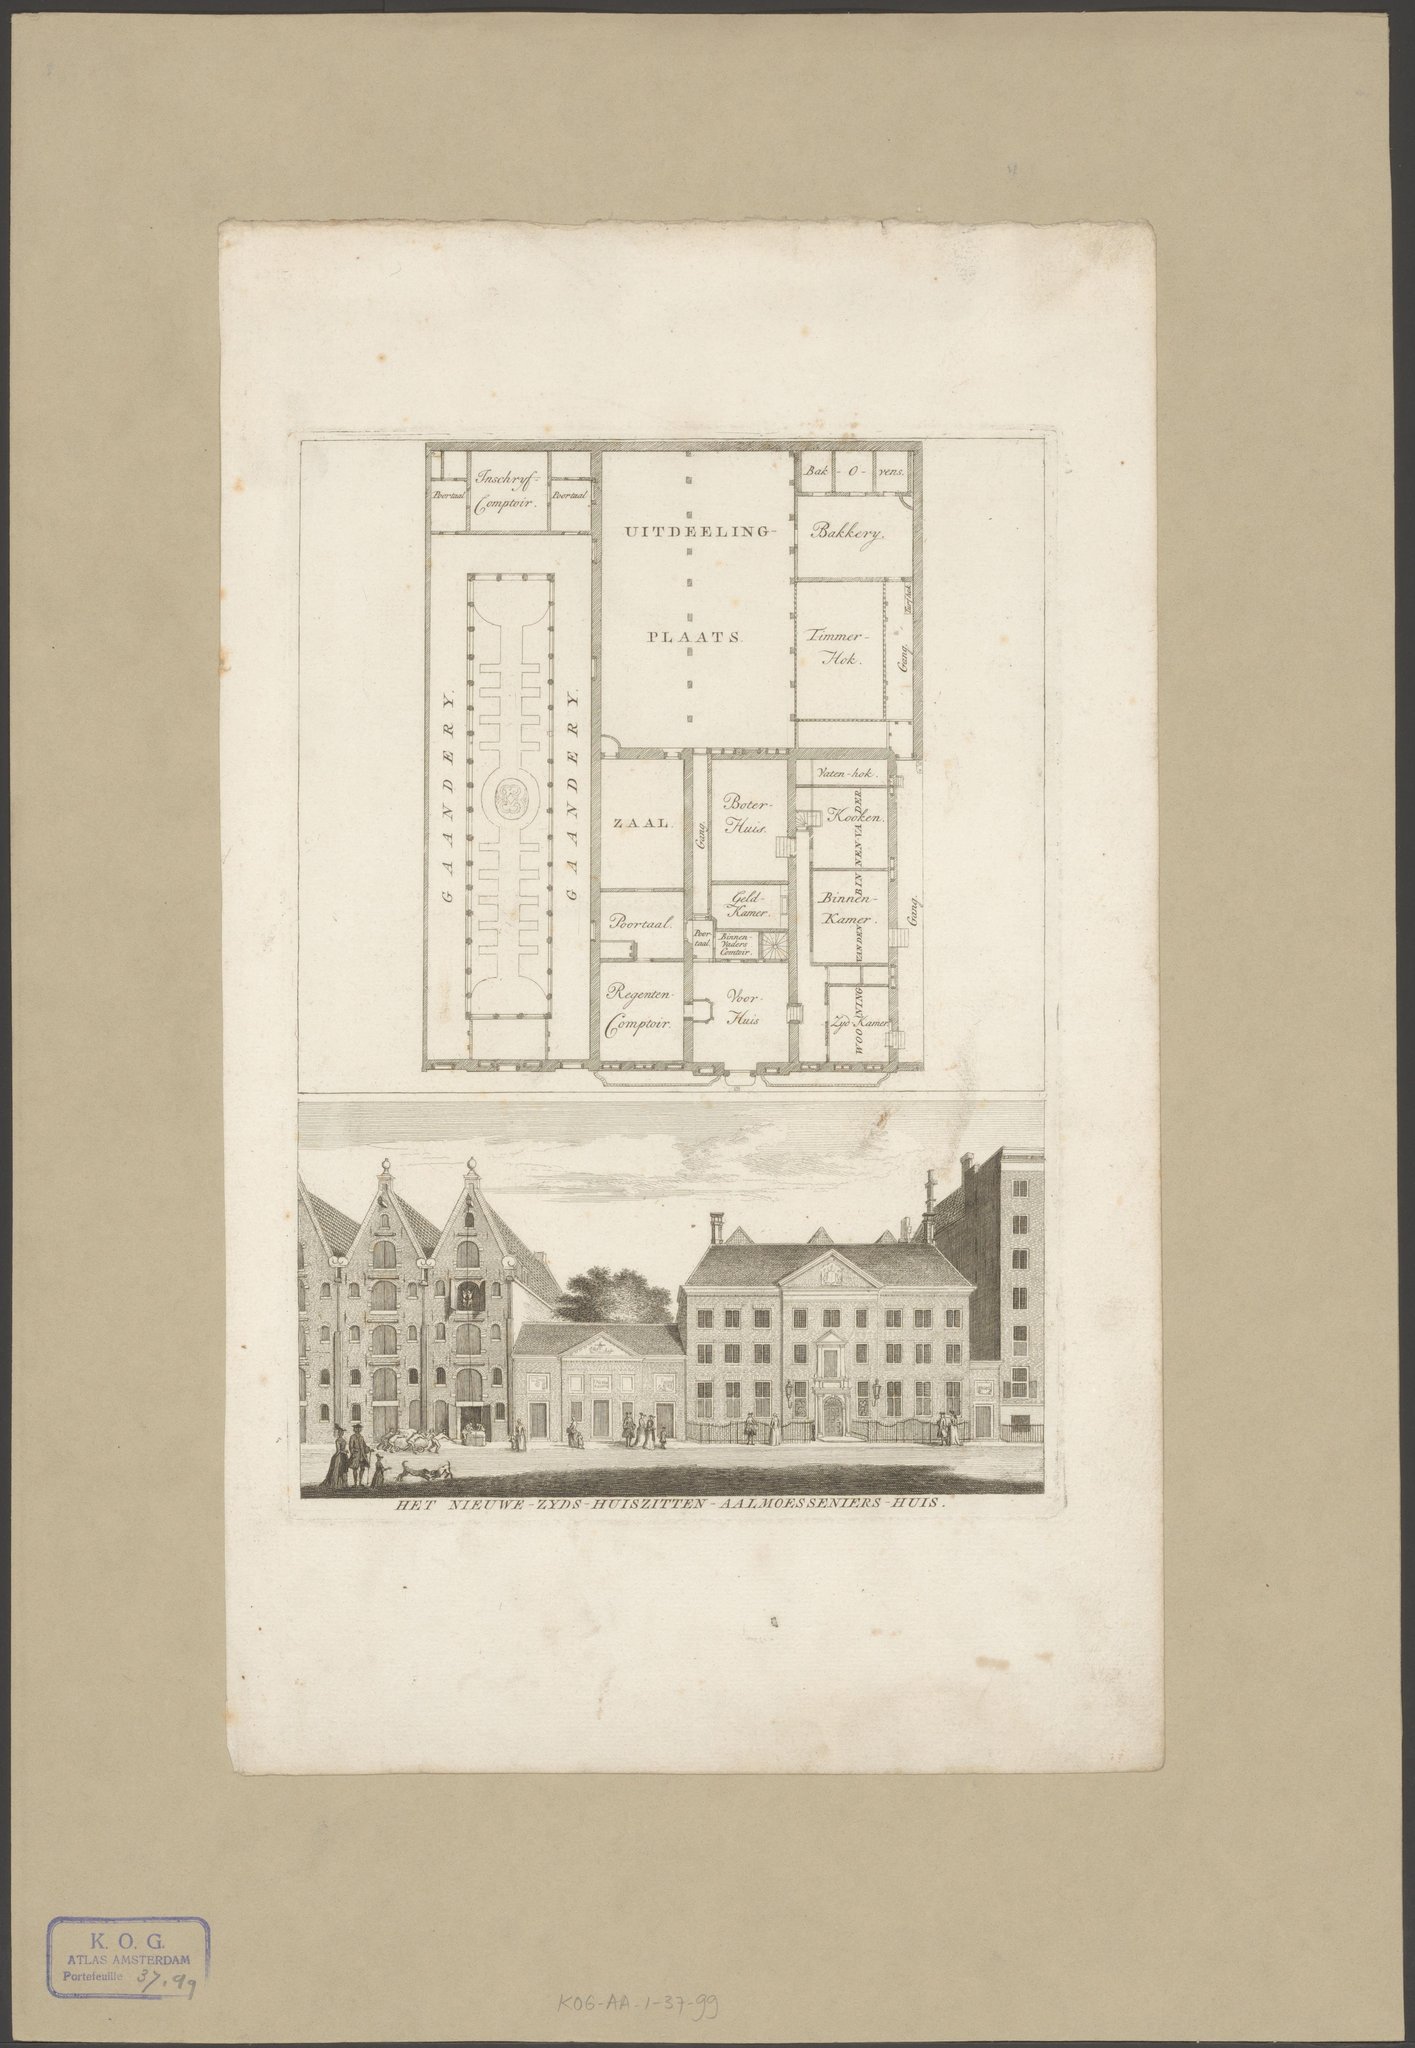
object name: area plan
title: Plattegrond van en gezicht op het Nieuwezijds Huiszittenhuis te Amsterdam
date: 1765-1782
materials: paper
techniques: engraving, etching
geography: harlingen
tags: poorhouse, floor plan ~ architectural design or model, street (+ city(-scape) with figures, staffage)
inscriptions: collector's mark: Lugt 1641b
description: Prent mogelijk uit: Wagenaar, Jan. Amsterdam, in zyne opkomst, aanwas, geschiedenissen (…). Amsterdam: Isaak Tirion, 1765, dl. 2. Of uit: Verzameling der fraaiste gezigten van Amsterdam in negen en zeventig afbeeldingen. Amsterdam en Harlingen: Petrus Conradi en Volkert van der Plaats, 1782.